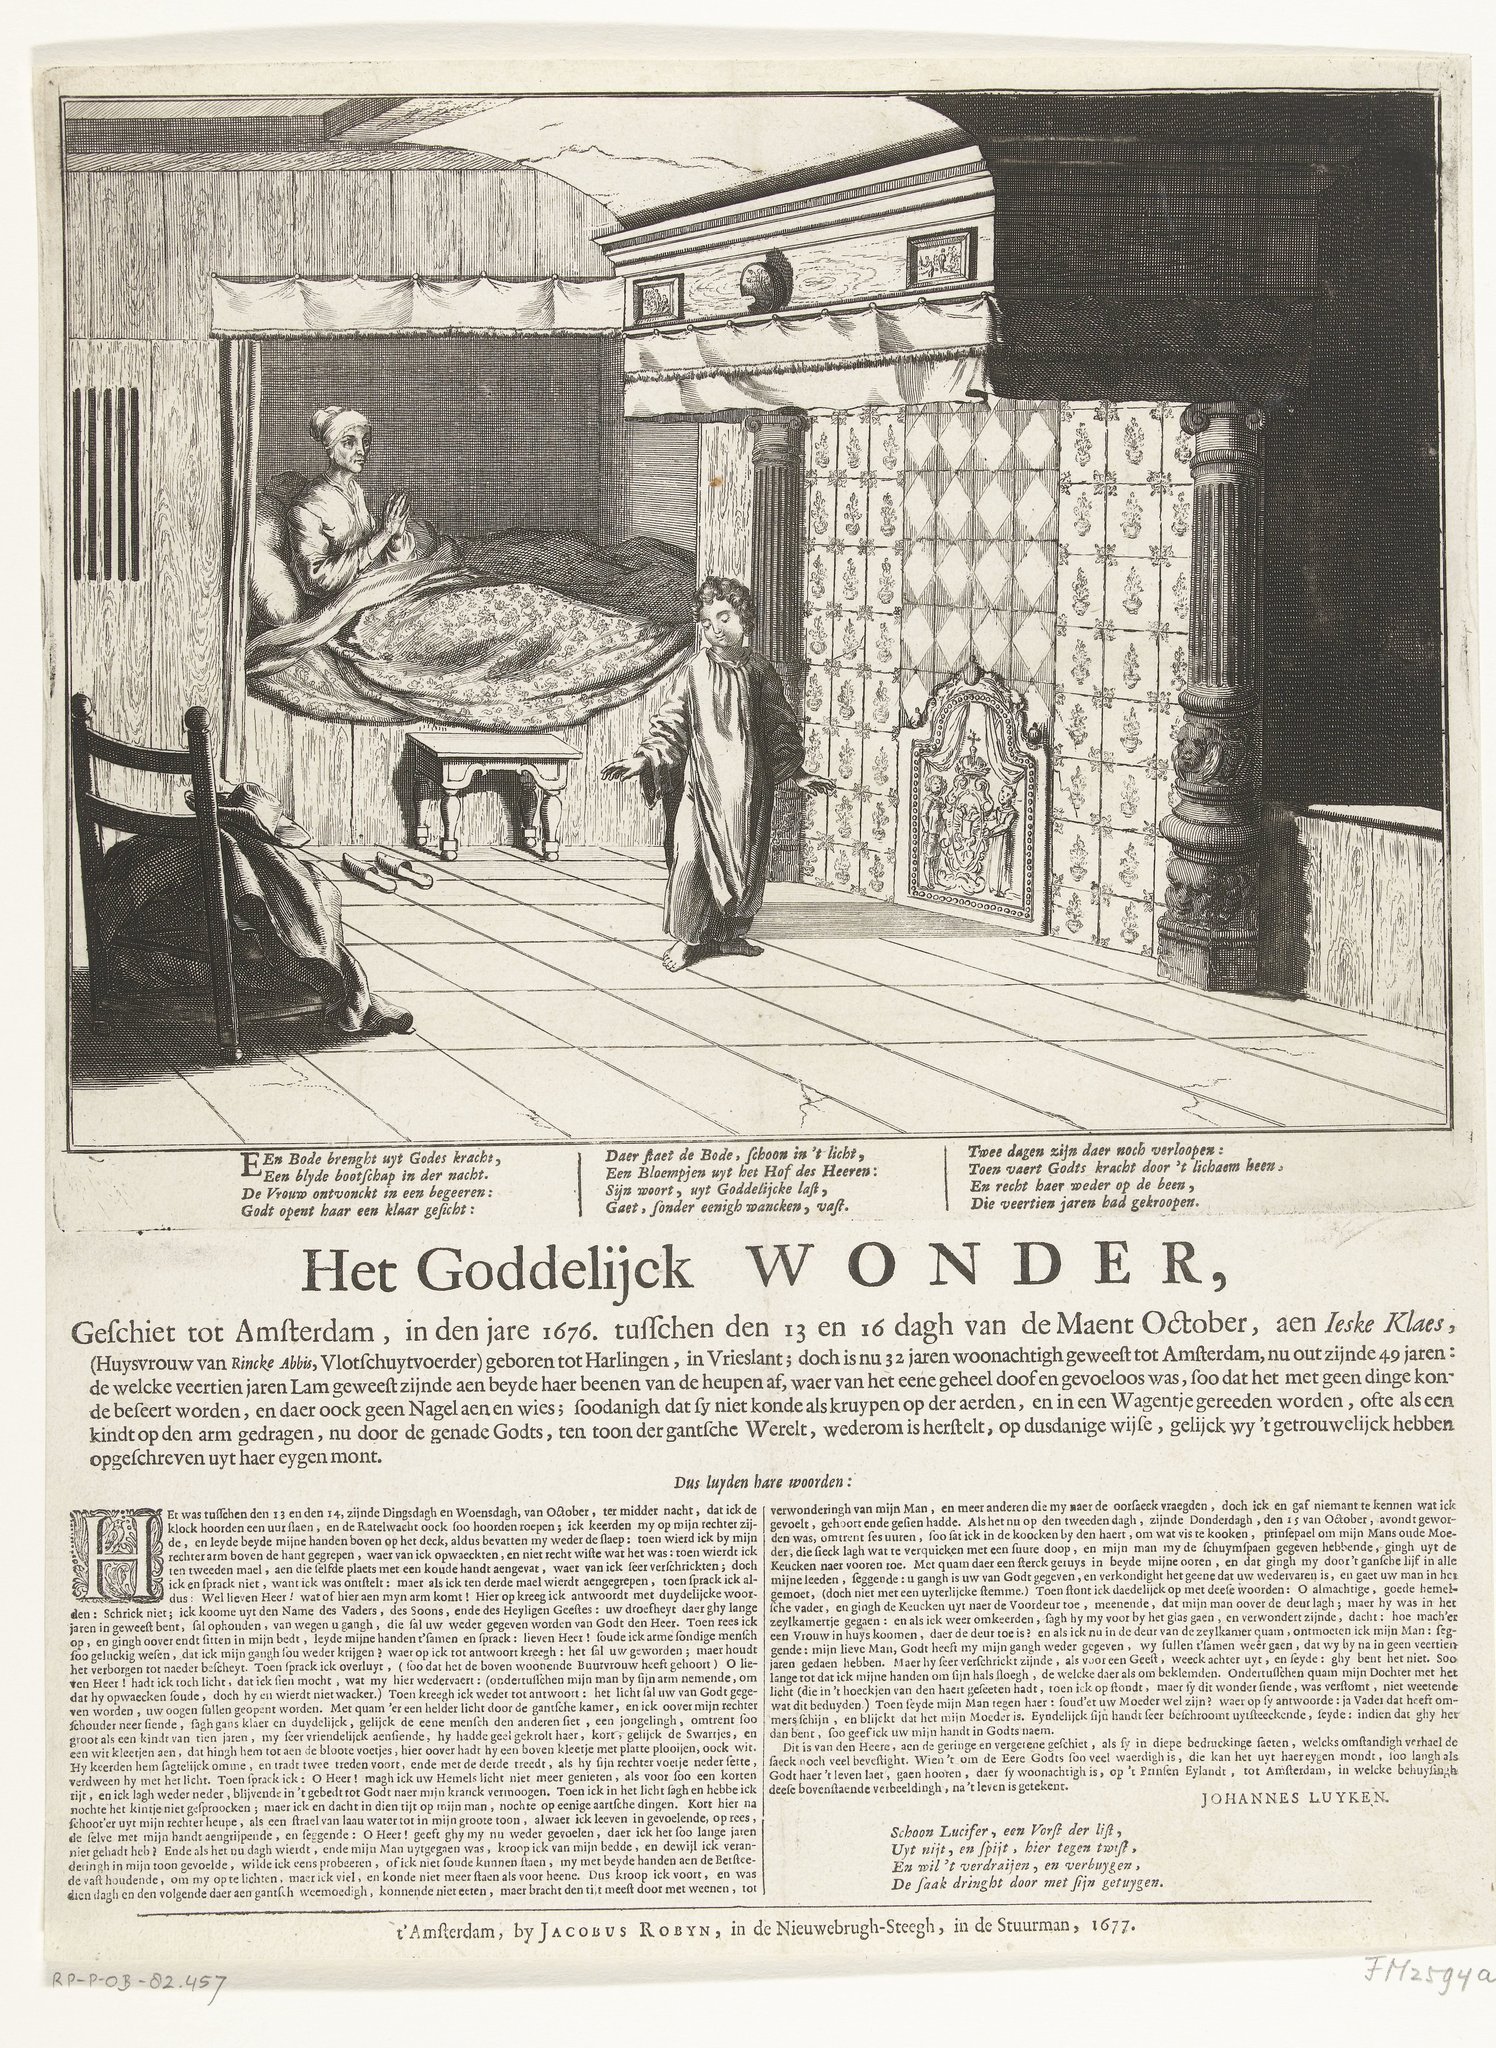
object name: print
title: Het Goddelijck Wonder, Geschiet tot Amsterdam, in den jare 1676, tusschen den 13 en 16 dagh van de Maent October, aen Jeske Klaes (...)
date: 1677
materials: paper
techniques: etching, letterpress printing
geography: northern netherlands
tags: miraculous healing, angels, amsterdam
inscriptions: date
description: De wonderbaarlijke genezing van Jeske Klaes, geschiedt tussen 13-16 oktober 1676 te Amsterdam. De vrouw zit overeind in haar bedstee en dankt de engel, in de vom van een jongen van ca. 10 jaren oud, voor de genezing van haar verlamde benen. In de plaat 3 verzen van 4 regels, daaronder op het blad een beschrijving van het wonder in 2 kolommen.